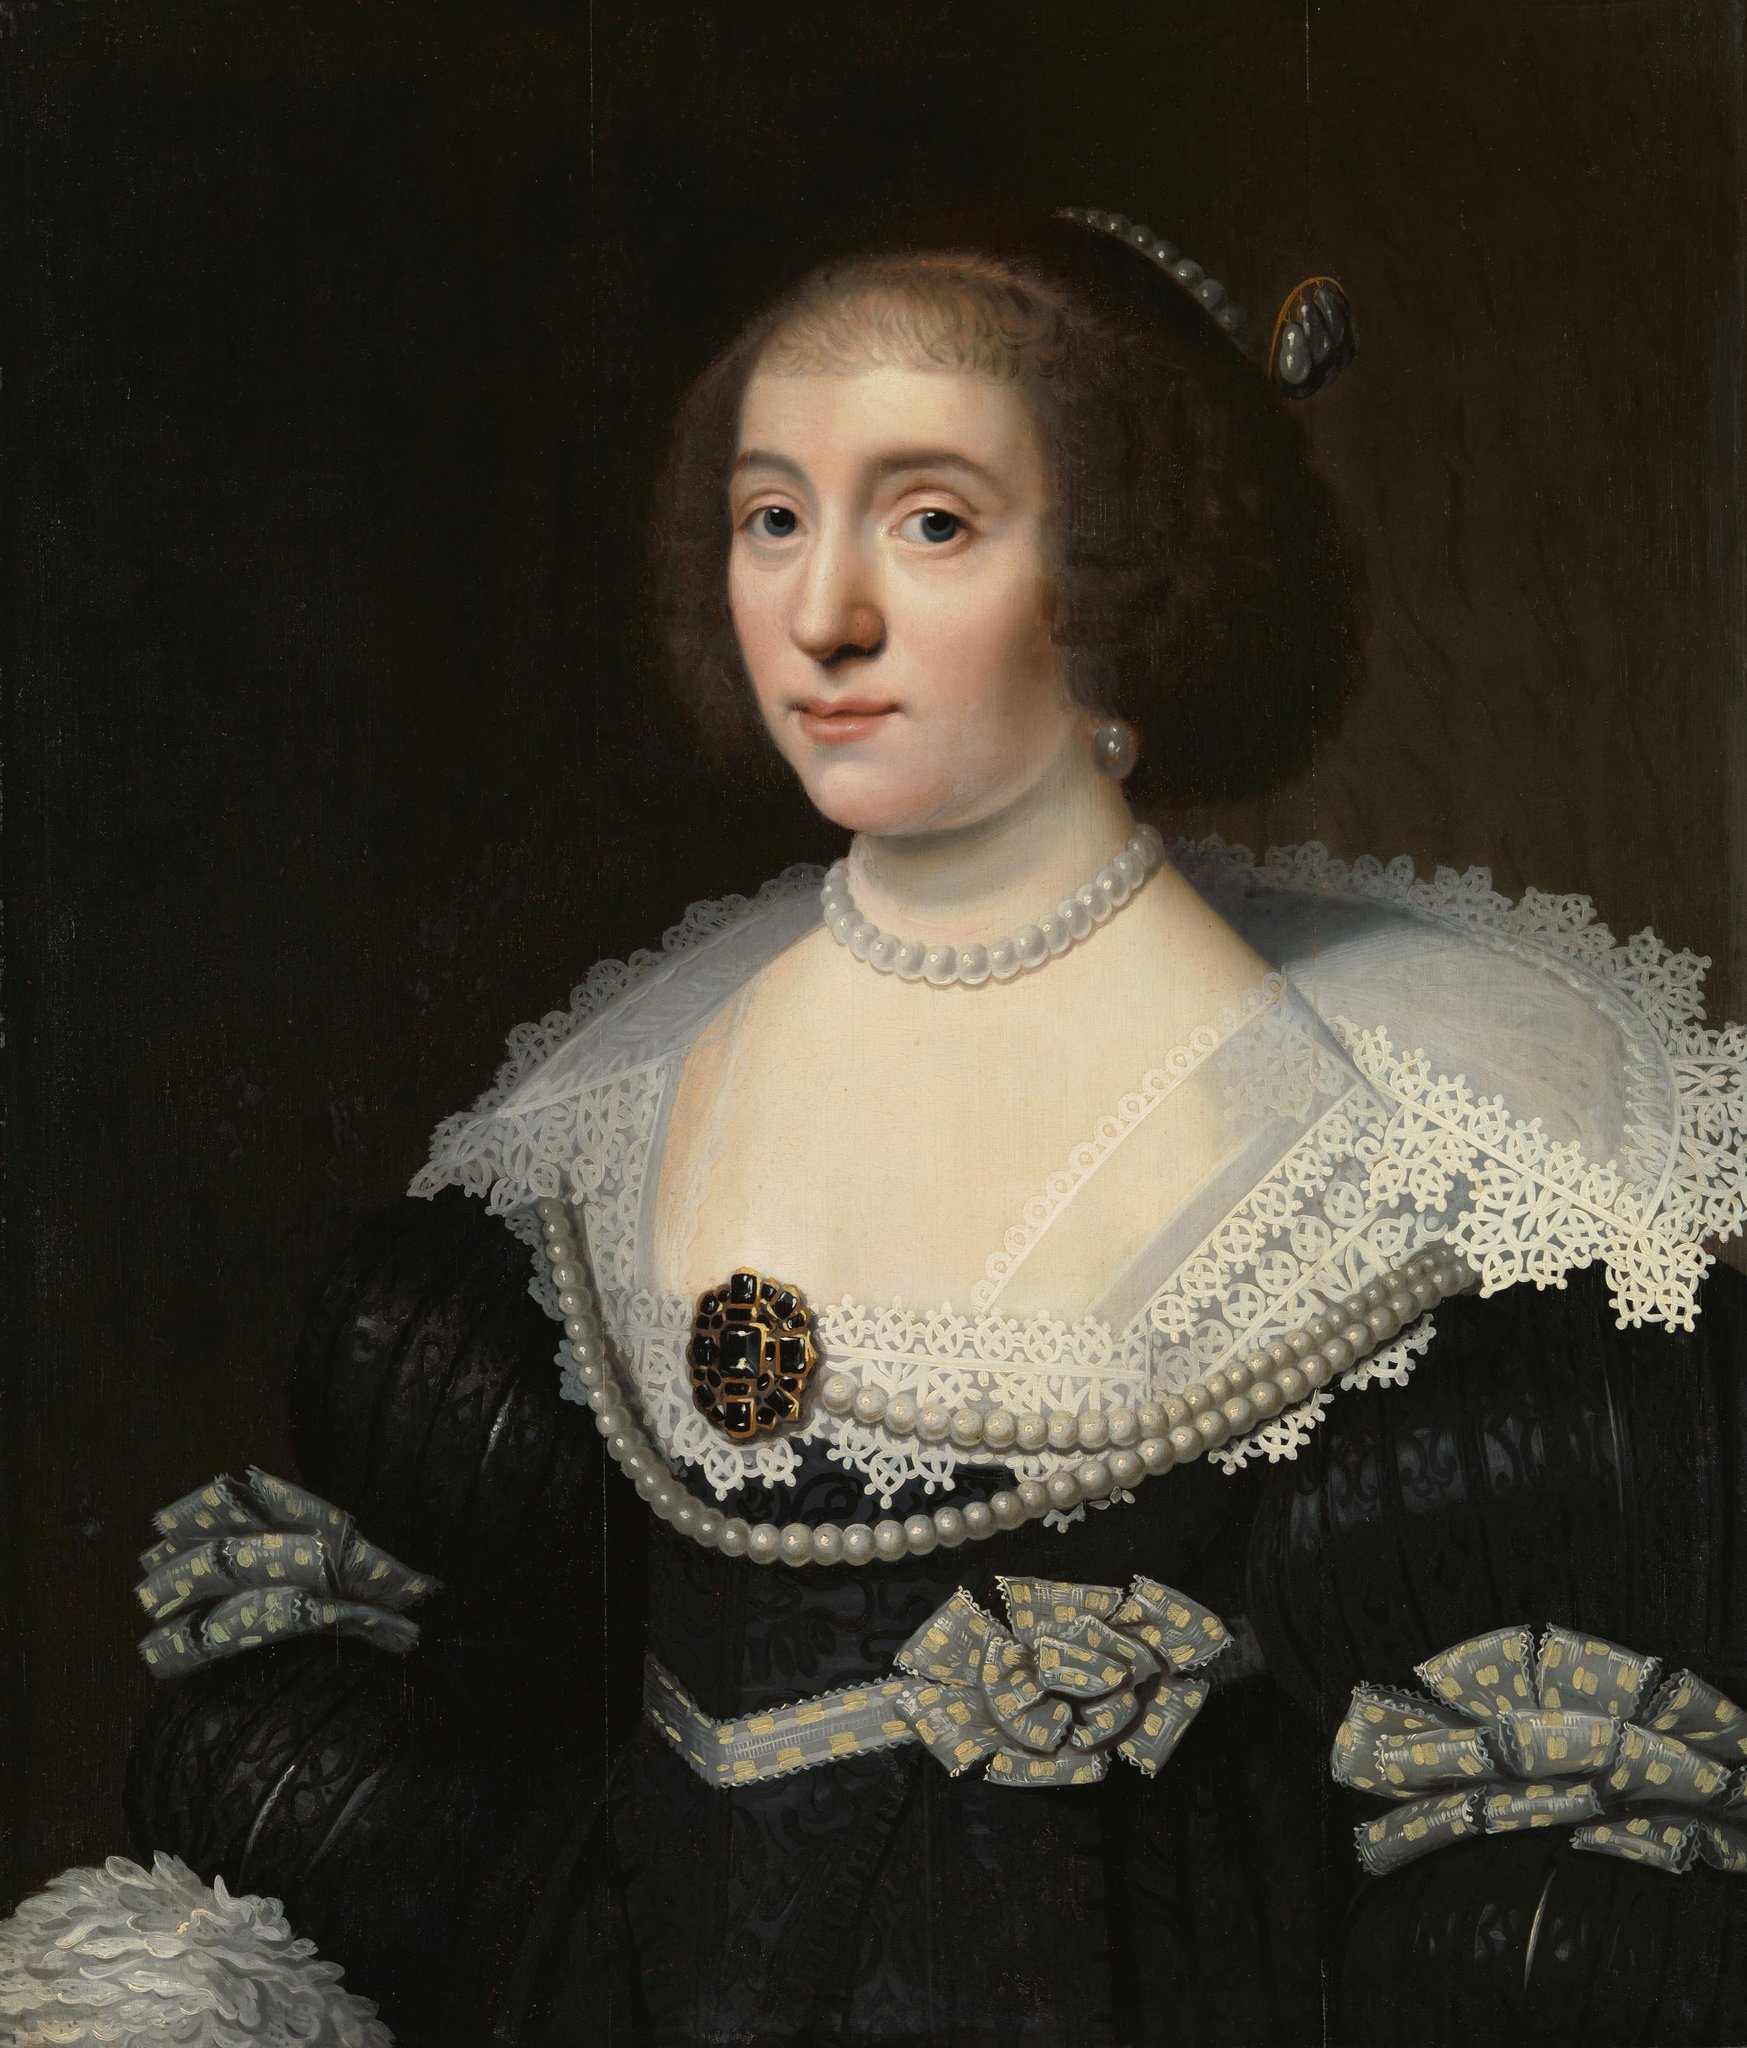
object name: painting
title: Sophia Hedwig von Braunschweig-Wolfenbüttel (1592-1642). Wife of Ernst Casimir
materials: oil, panel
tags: delft, frederick henry (prince of orange), amalia of solms-braunfels, historical persons - bb - woman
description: Portret van Sophia Hedwig von Braunschweig-Wolfenbüttel, echtgenote van Ernst Casimir. Buste naar links, met sieraden op de borst en in het haar. Pendant van SK-A-571.